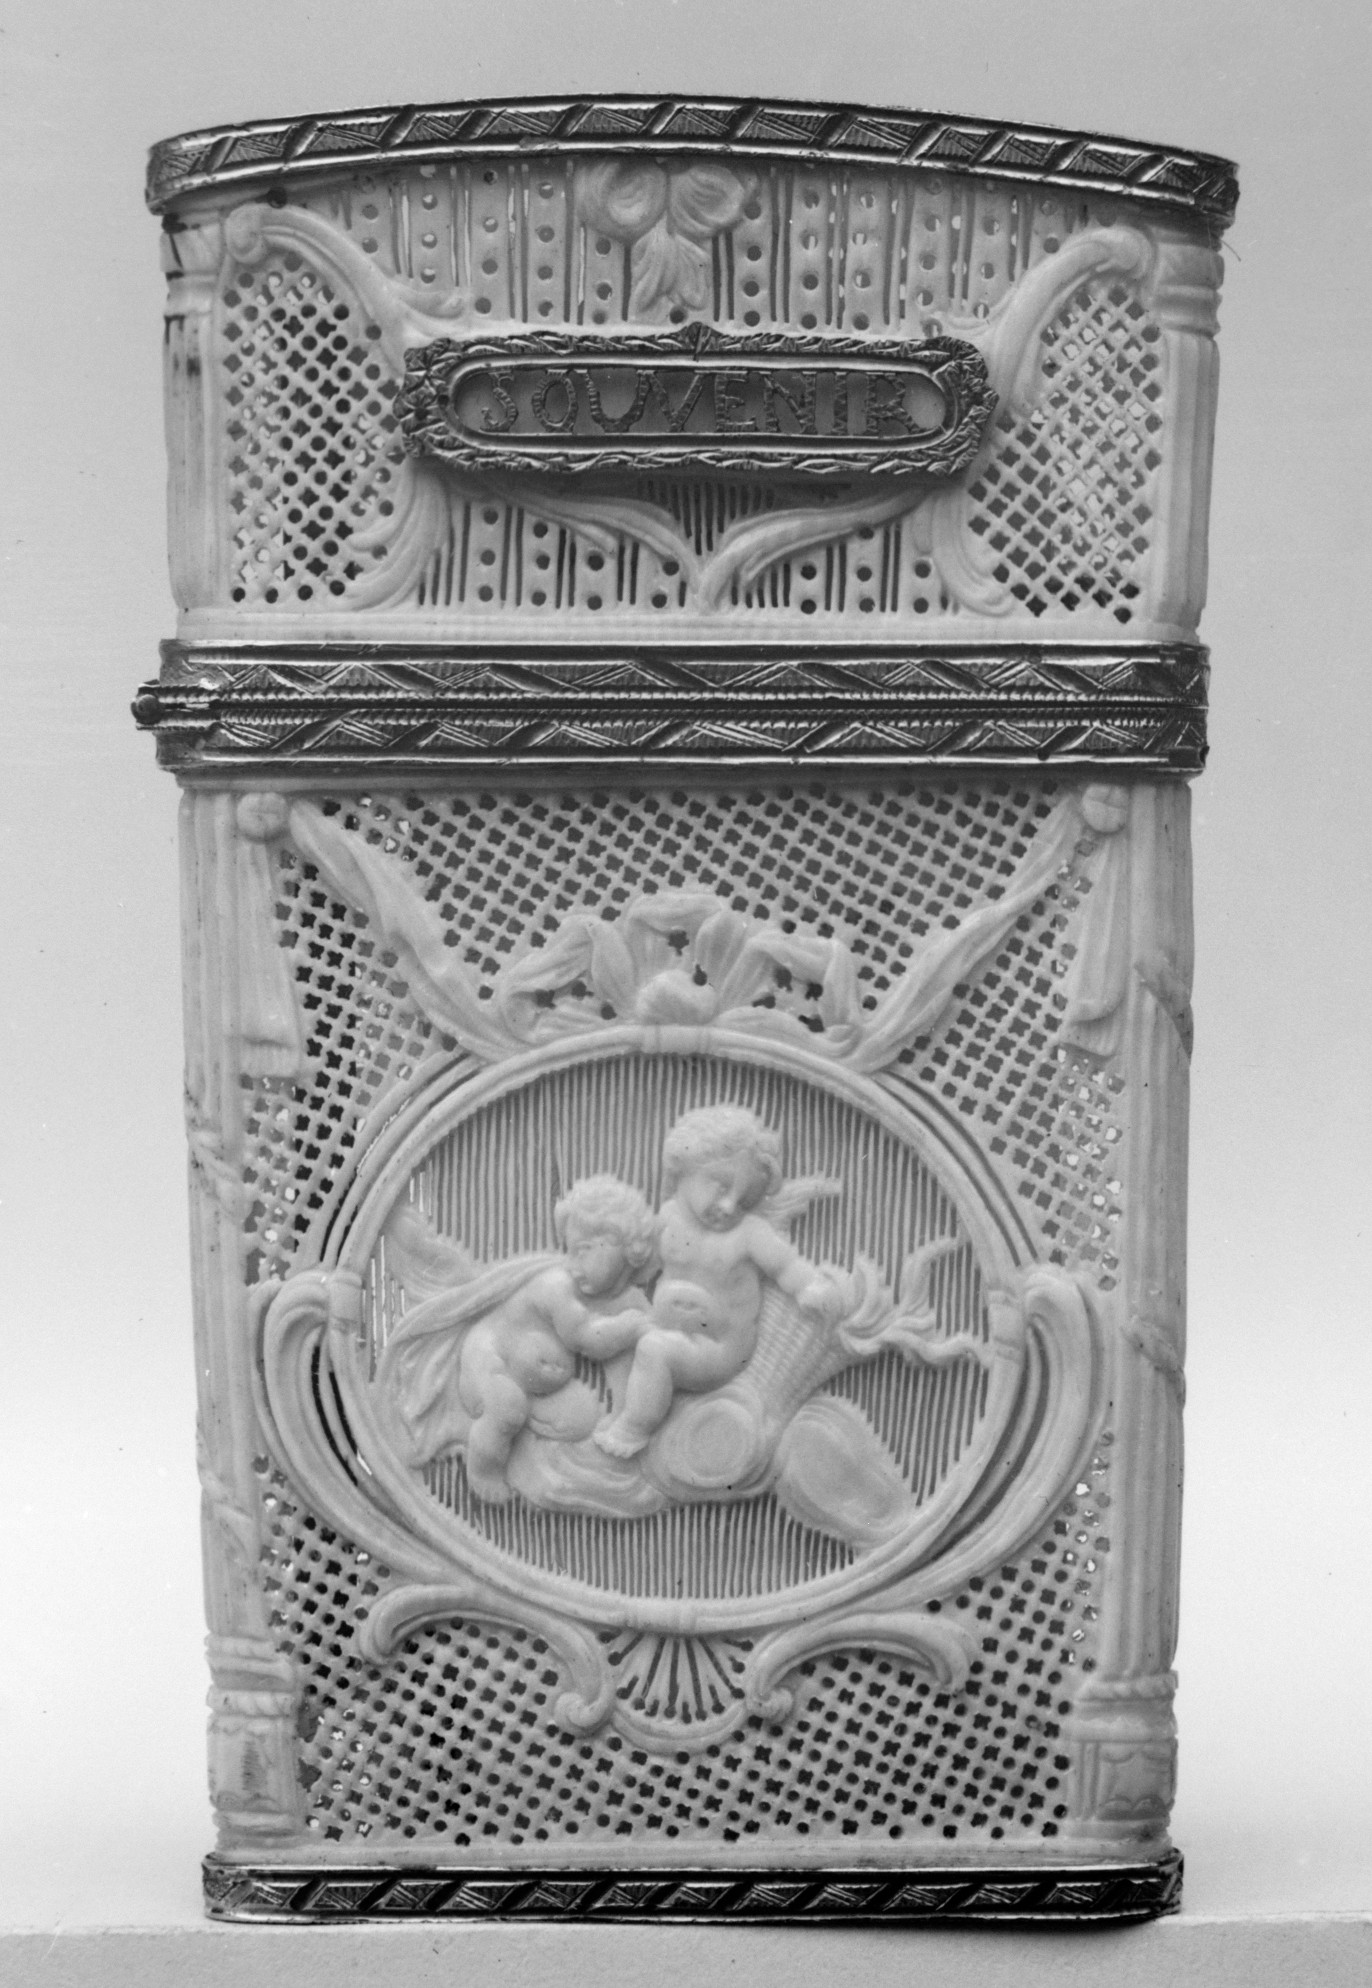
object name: souvenir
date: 1773-1774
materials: gold, ivory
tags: cupid